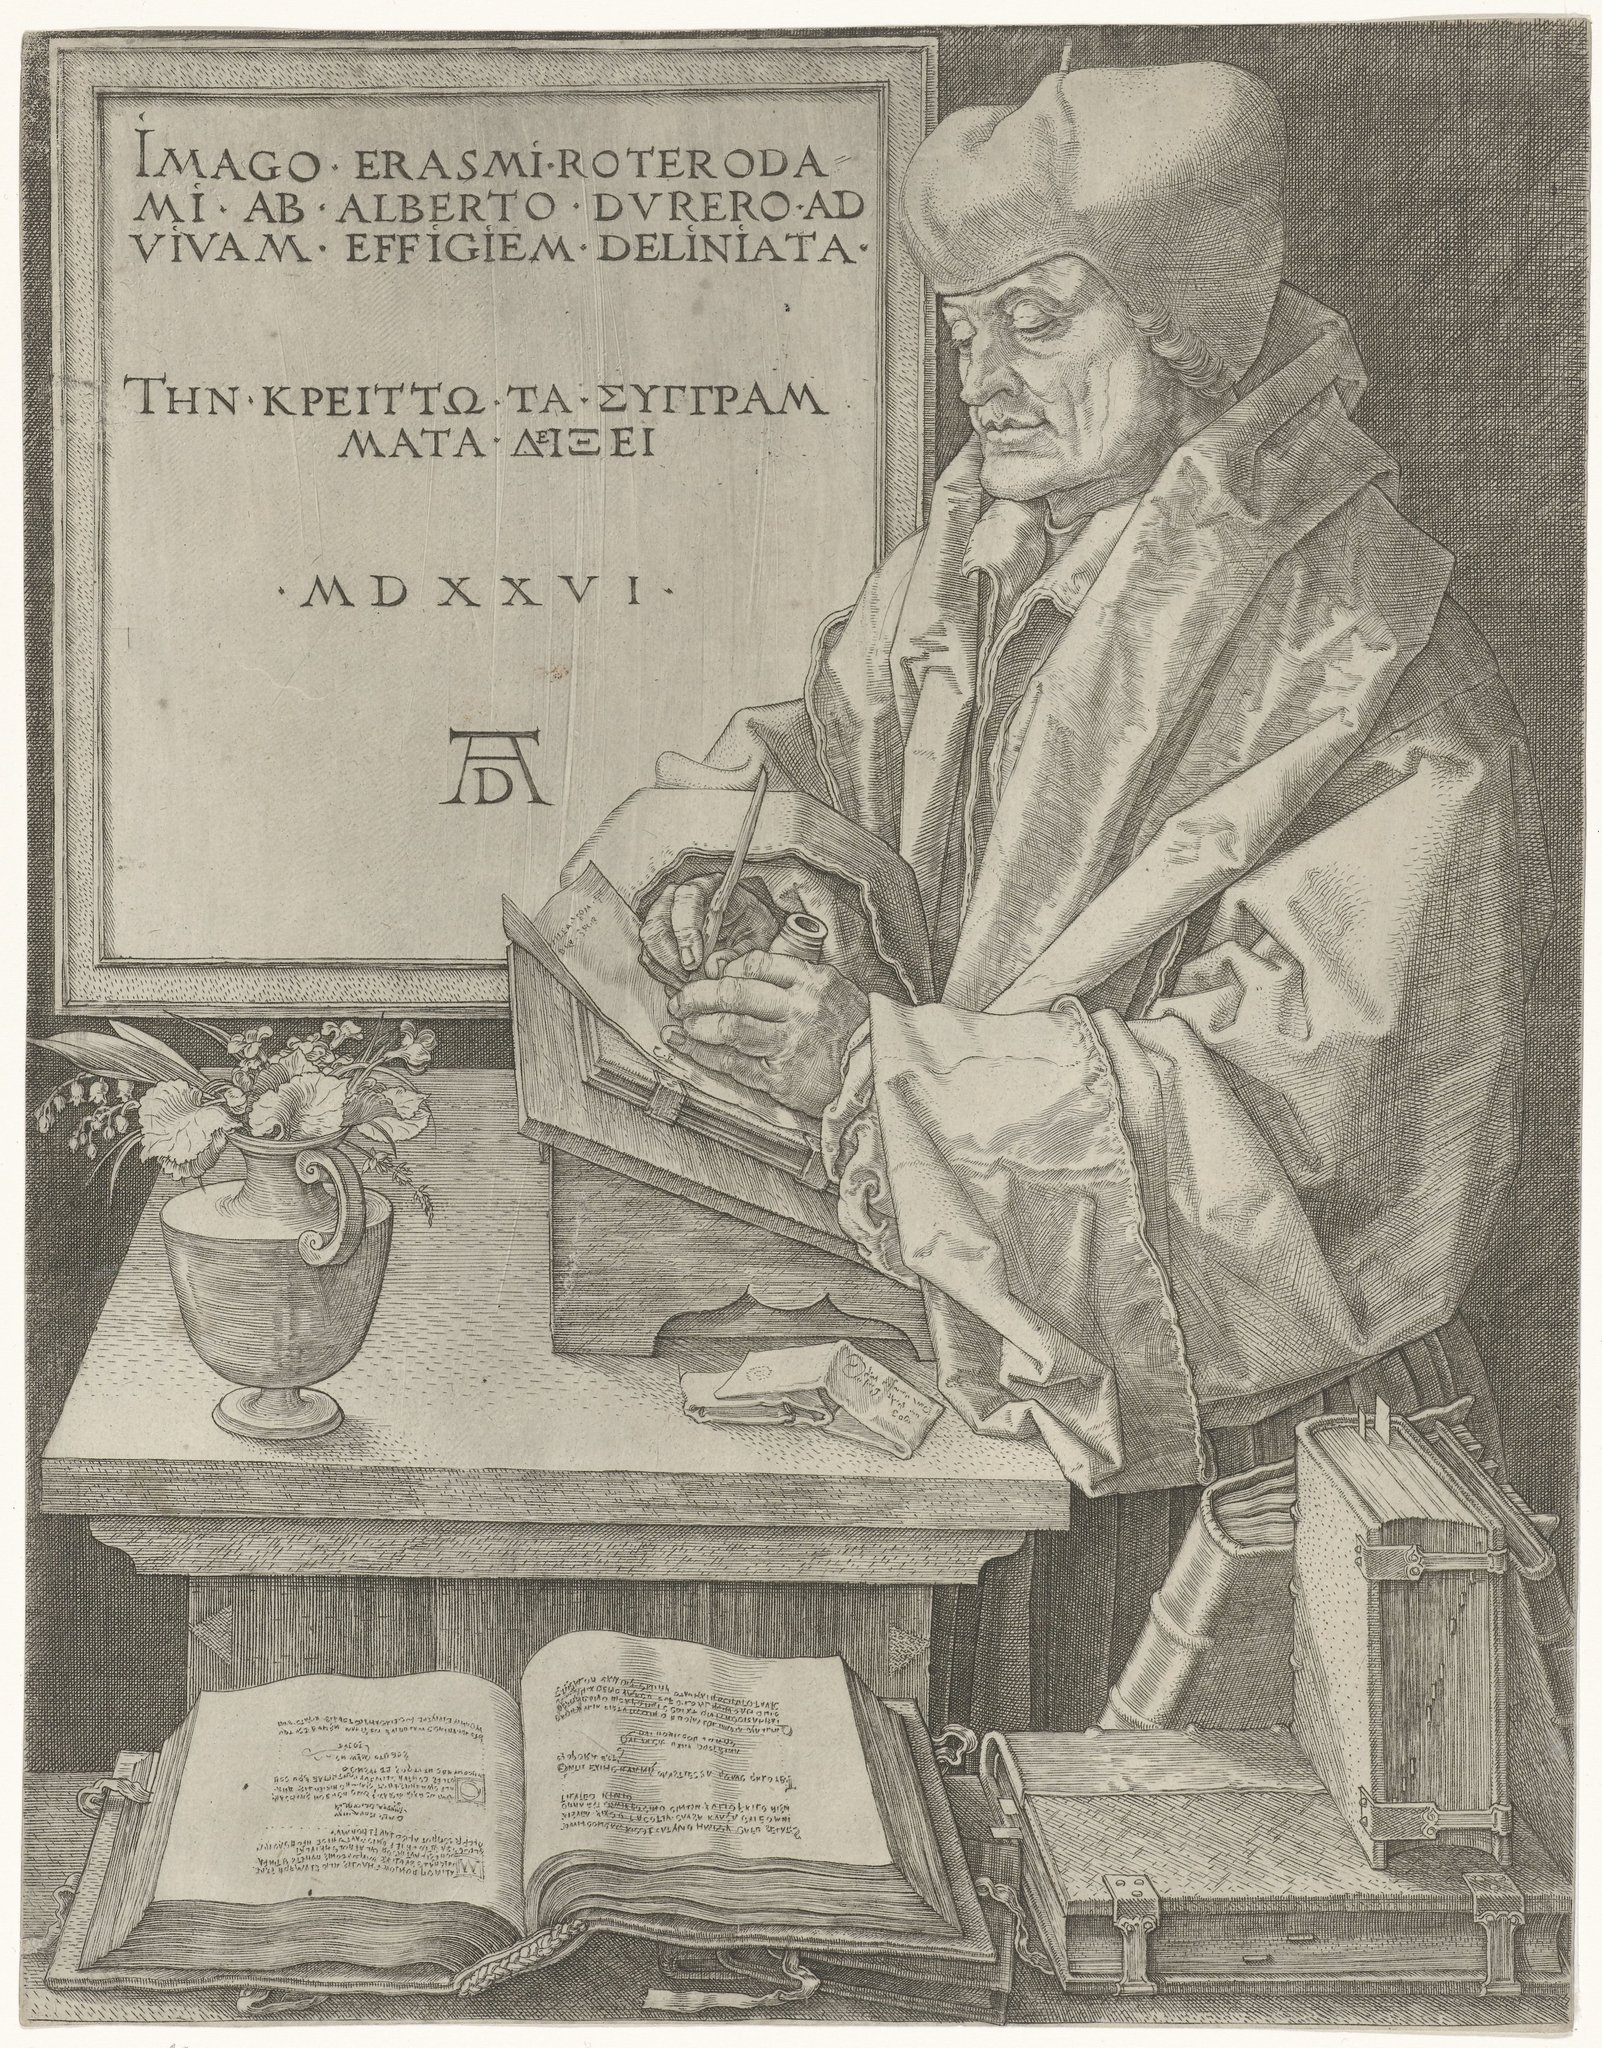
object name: print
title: Portret van Erasmus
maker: albrecht dürer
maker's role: draughtsman, painter, print maker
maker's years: 1471-1528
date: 1526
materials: paper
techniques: engraving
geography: nuremberg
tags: rotterdam, desiderius erasmus, historical persons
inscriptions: date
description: Portret van Erasmus, schrijvend, staande aan een lezenaar bij een tafel waarop een vaas met bloemen staat. Achter de tafel een tablet aan de wand met Latijnse tekst.